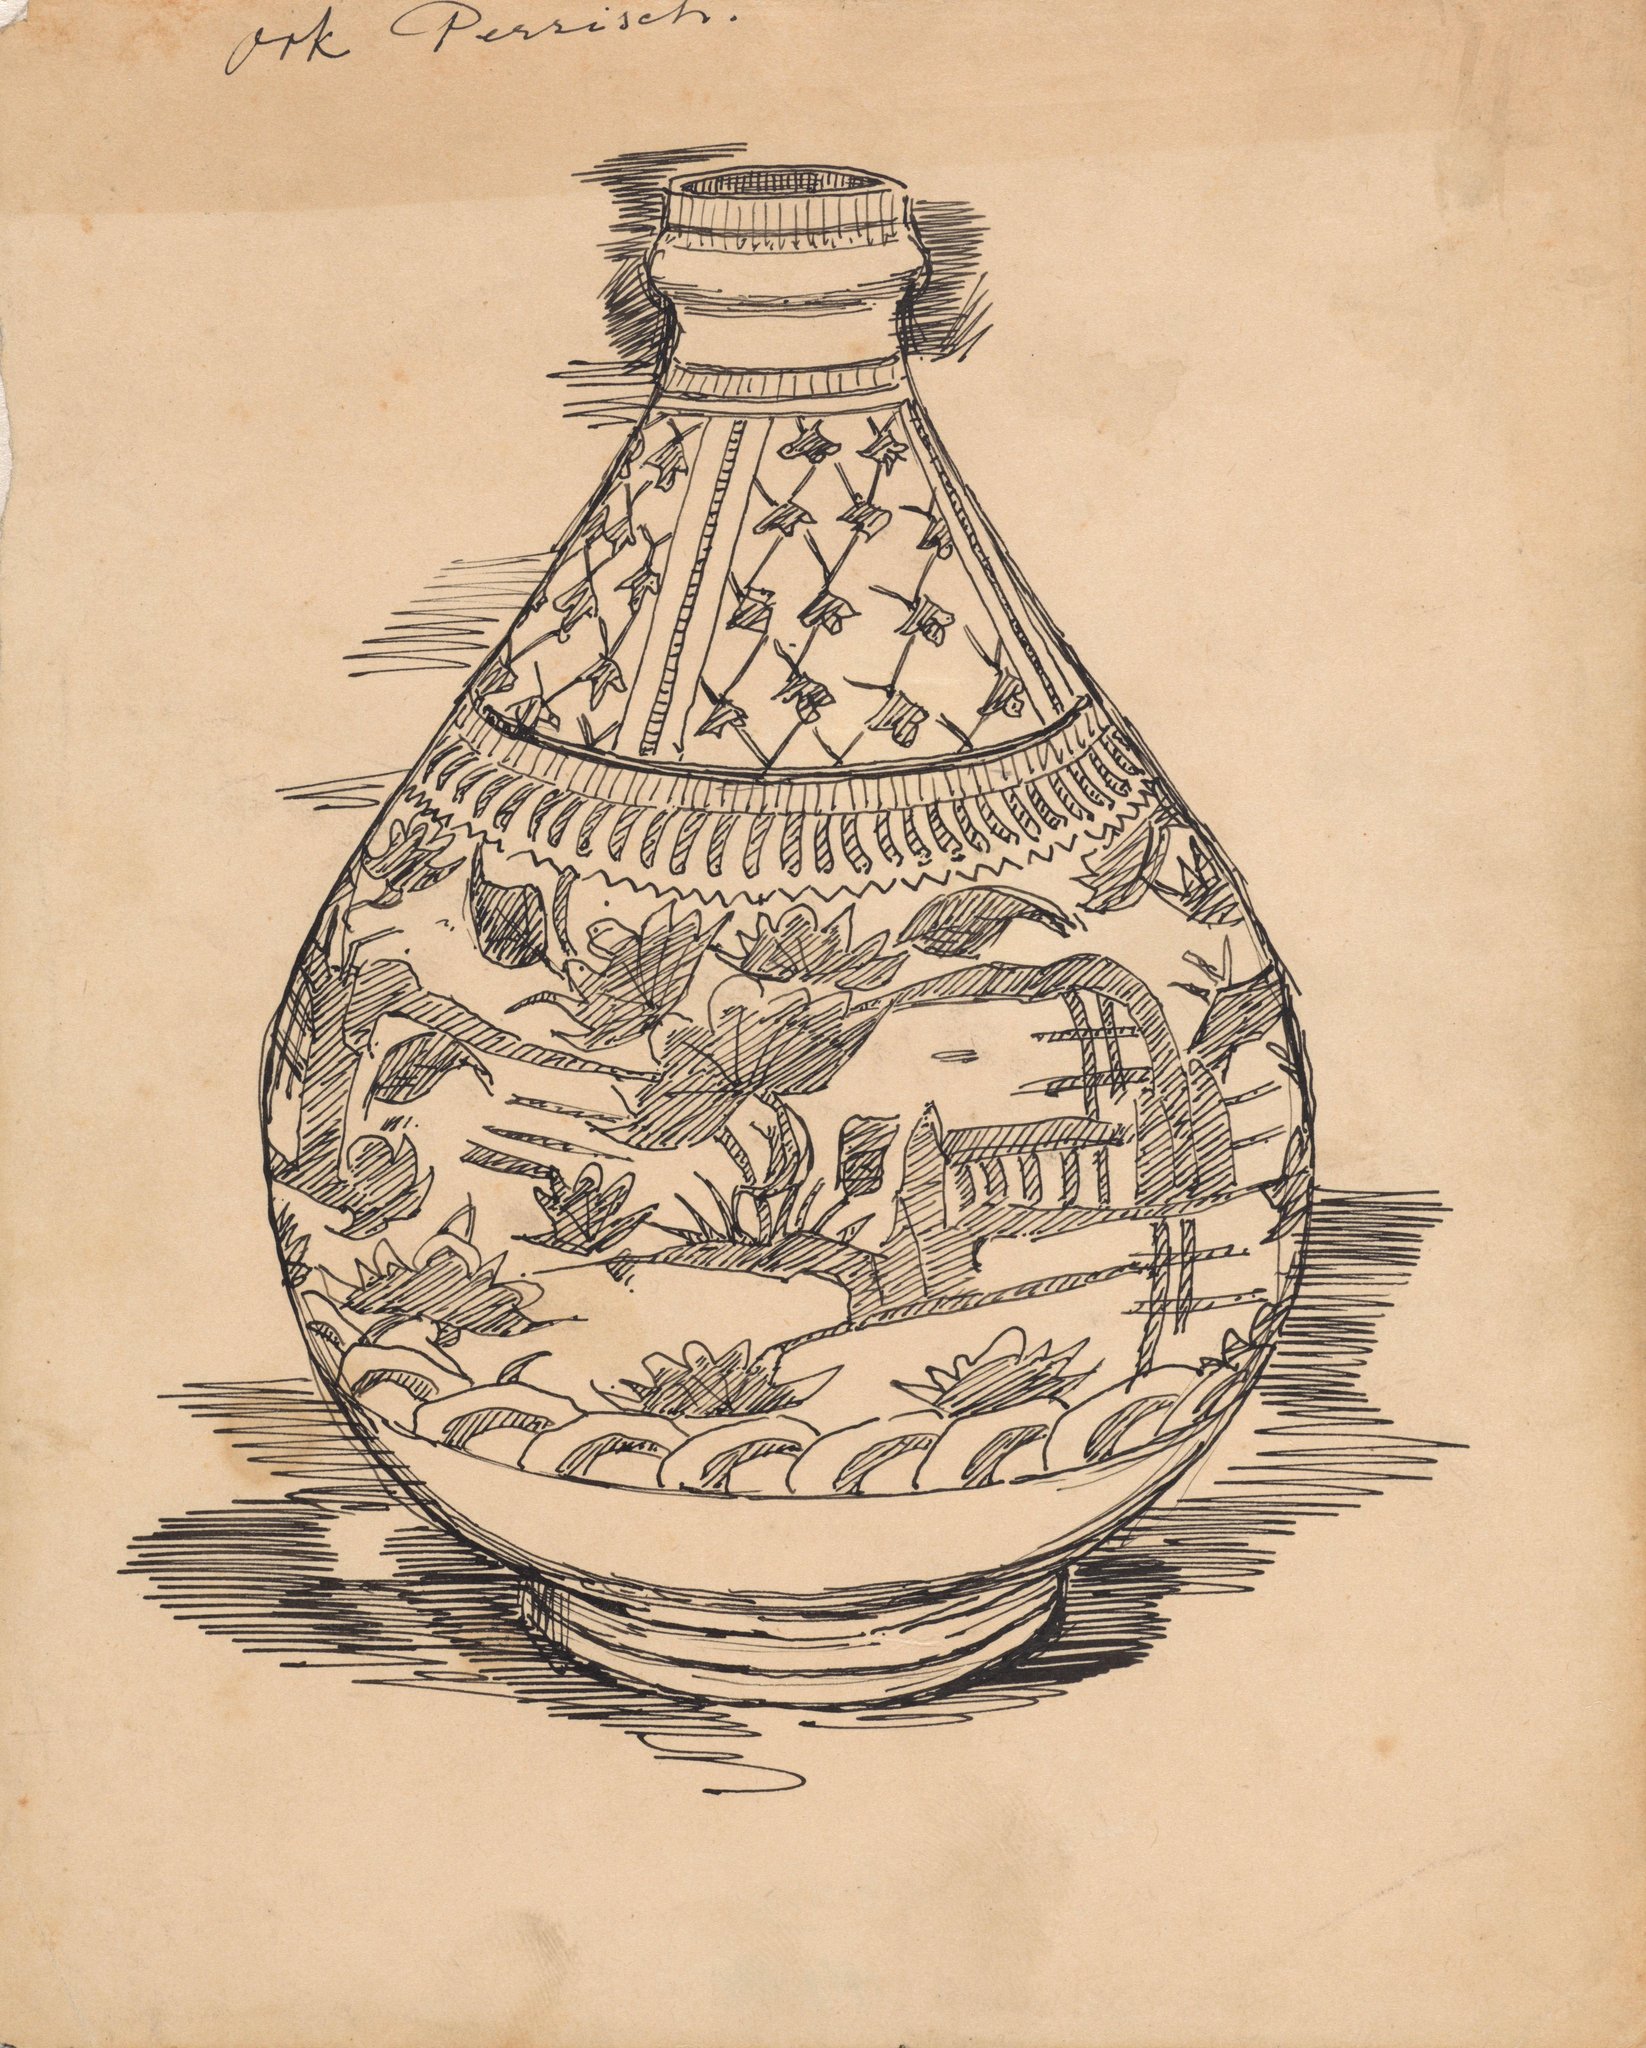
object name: drawing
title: Perzische vaas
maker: theo nieuwenhuis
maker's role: designer, draughtsman, print maker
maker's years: 1866-1951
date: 1876-1951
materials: ink, paper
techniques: pen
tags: work of applied art (+ other non-european art developments), container of ceramics: jar, jug, pot, vase